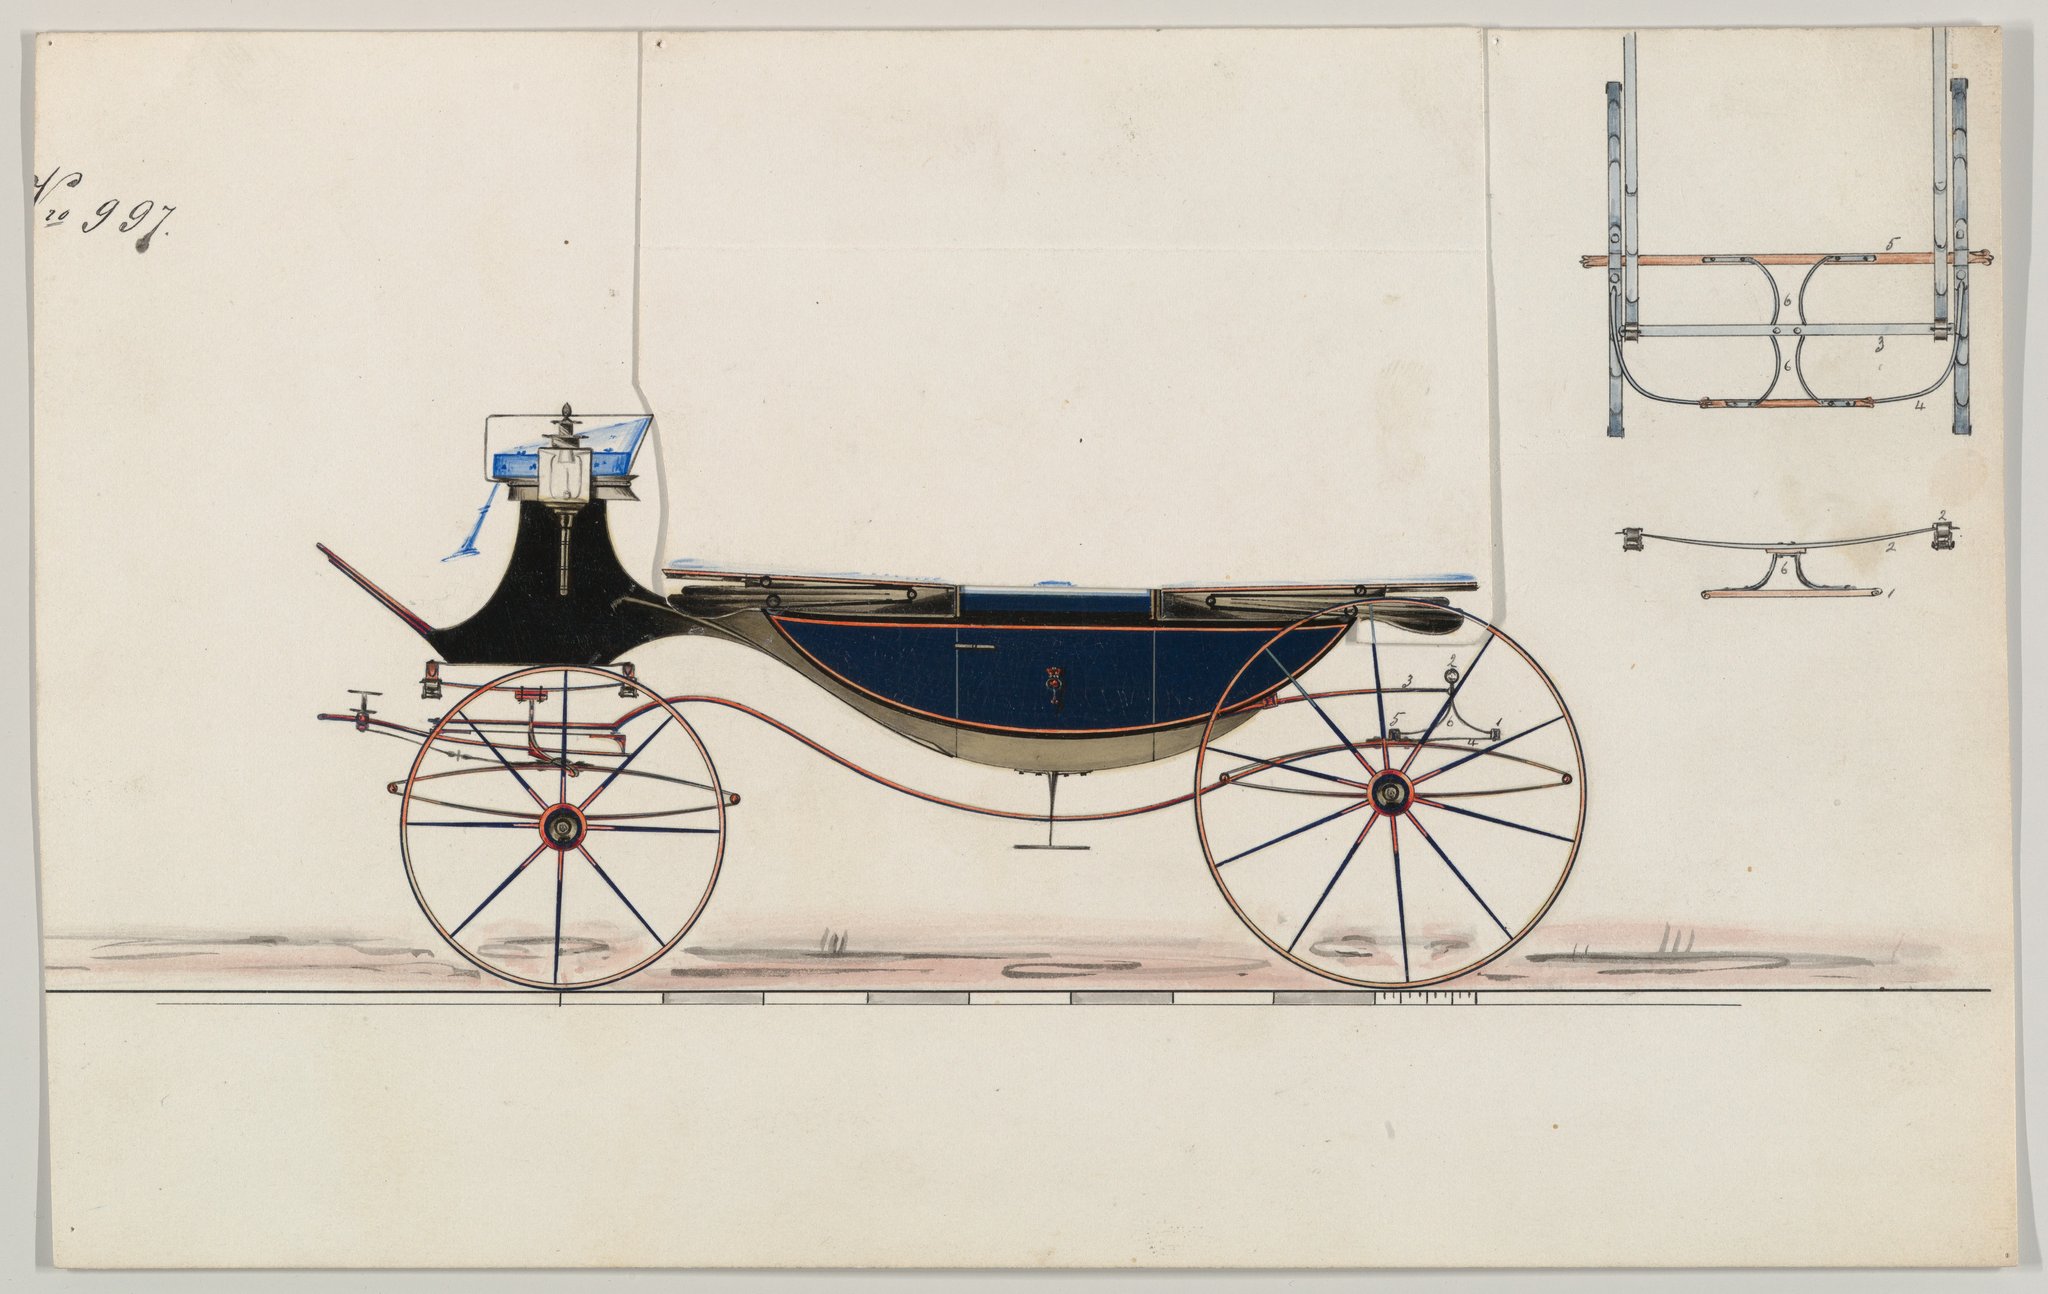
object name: drawing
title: Landau #997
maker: brewster & co.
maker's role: manufacturer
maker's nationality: american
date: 1850-1870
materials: gouache, gum arabic, ink, watercolor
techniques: pen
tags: carriages